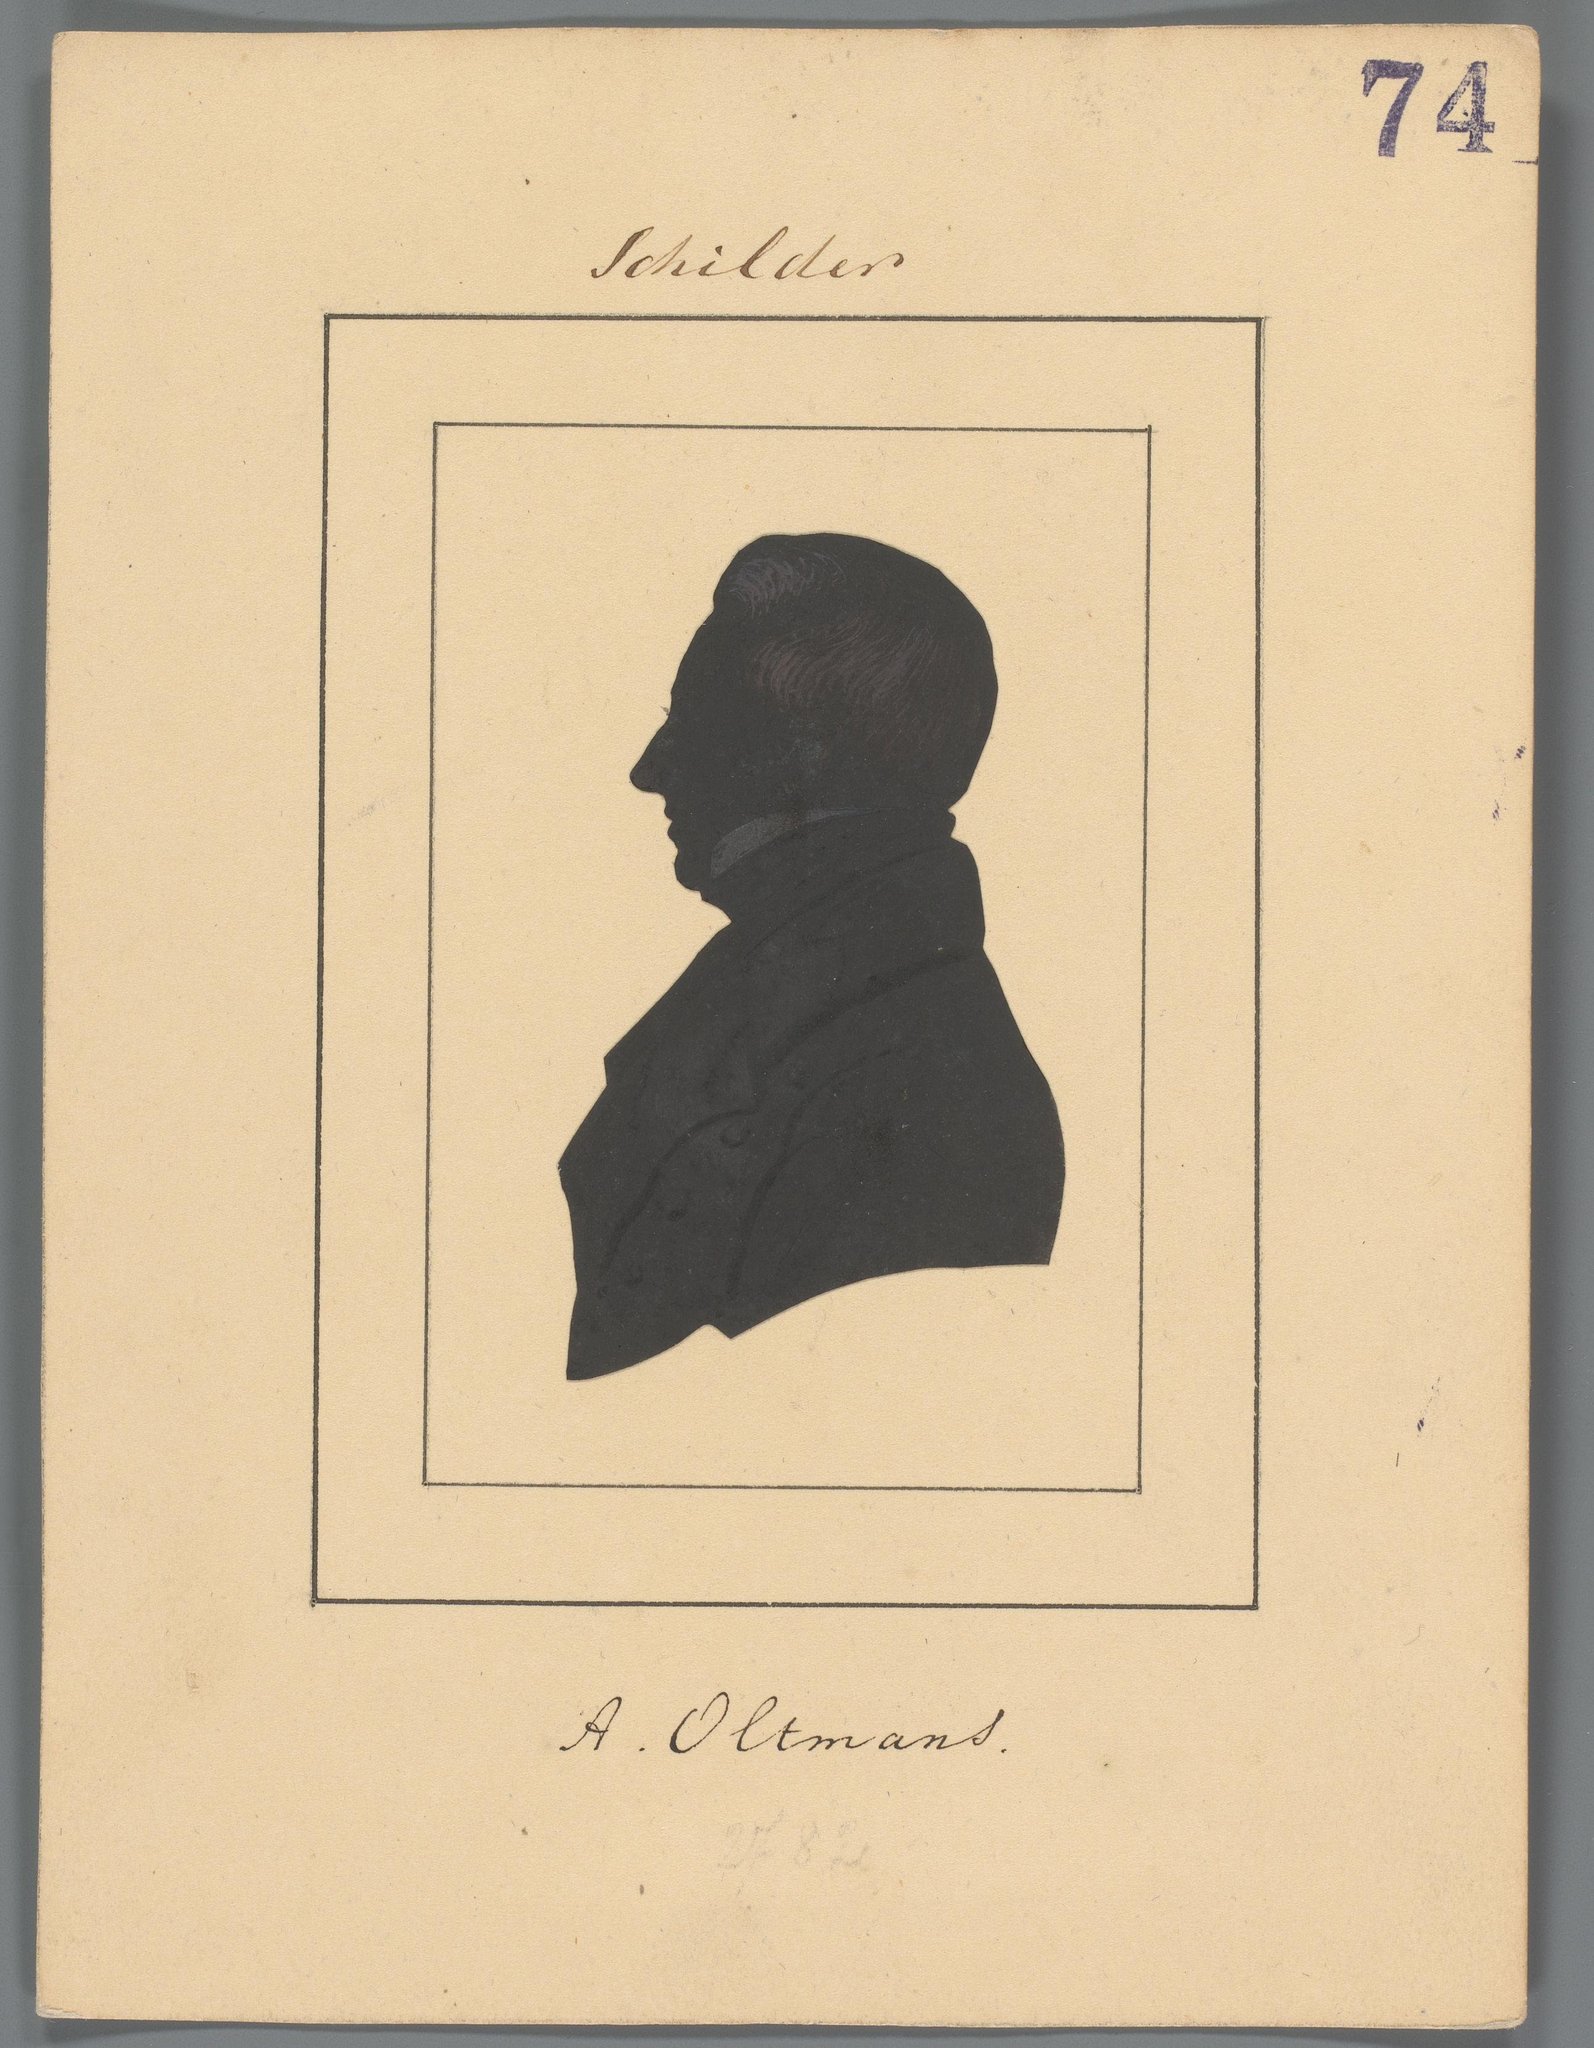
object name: drawing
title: Silhouetportret van Alexander Oltmans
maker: elisabeth alida haanen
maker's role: draughtsman, print maker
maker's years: 1809-1845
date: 1819-1845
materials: ink, paint, paper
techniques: brush, snipping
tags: alexander oltmans, historical persons, portrait, self-portrait of painter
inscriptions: inscription: ‘Schilder’, inscription: ‘Neg. D. 1789’, number: ‘74’, collector's mark: ‘Ex-libris van Beresteyn’, inscription: ‘A. Oltmans.’, number: ‘14000’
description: Met onder het portret de handtekening van de geportretteerde.